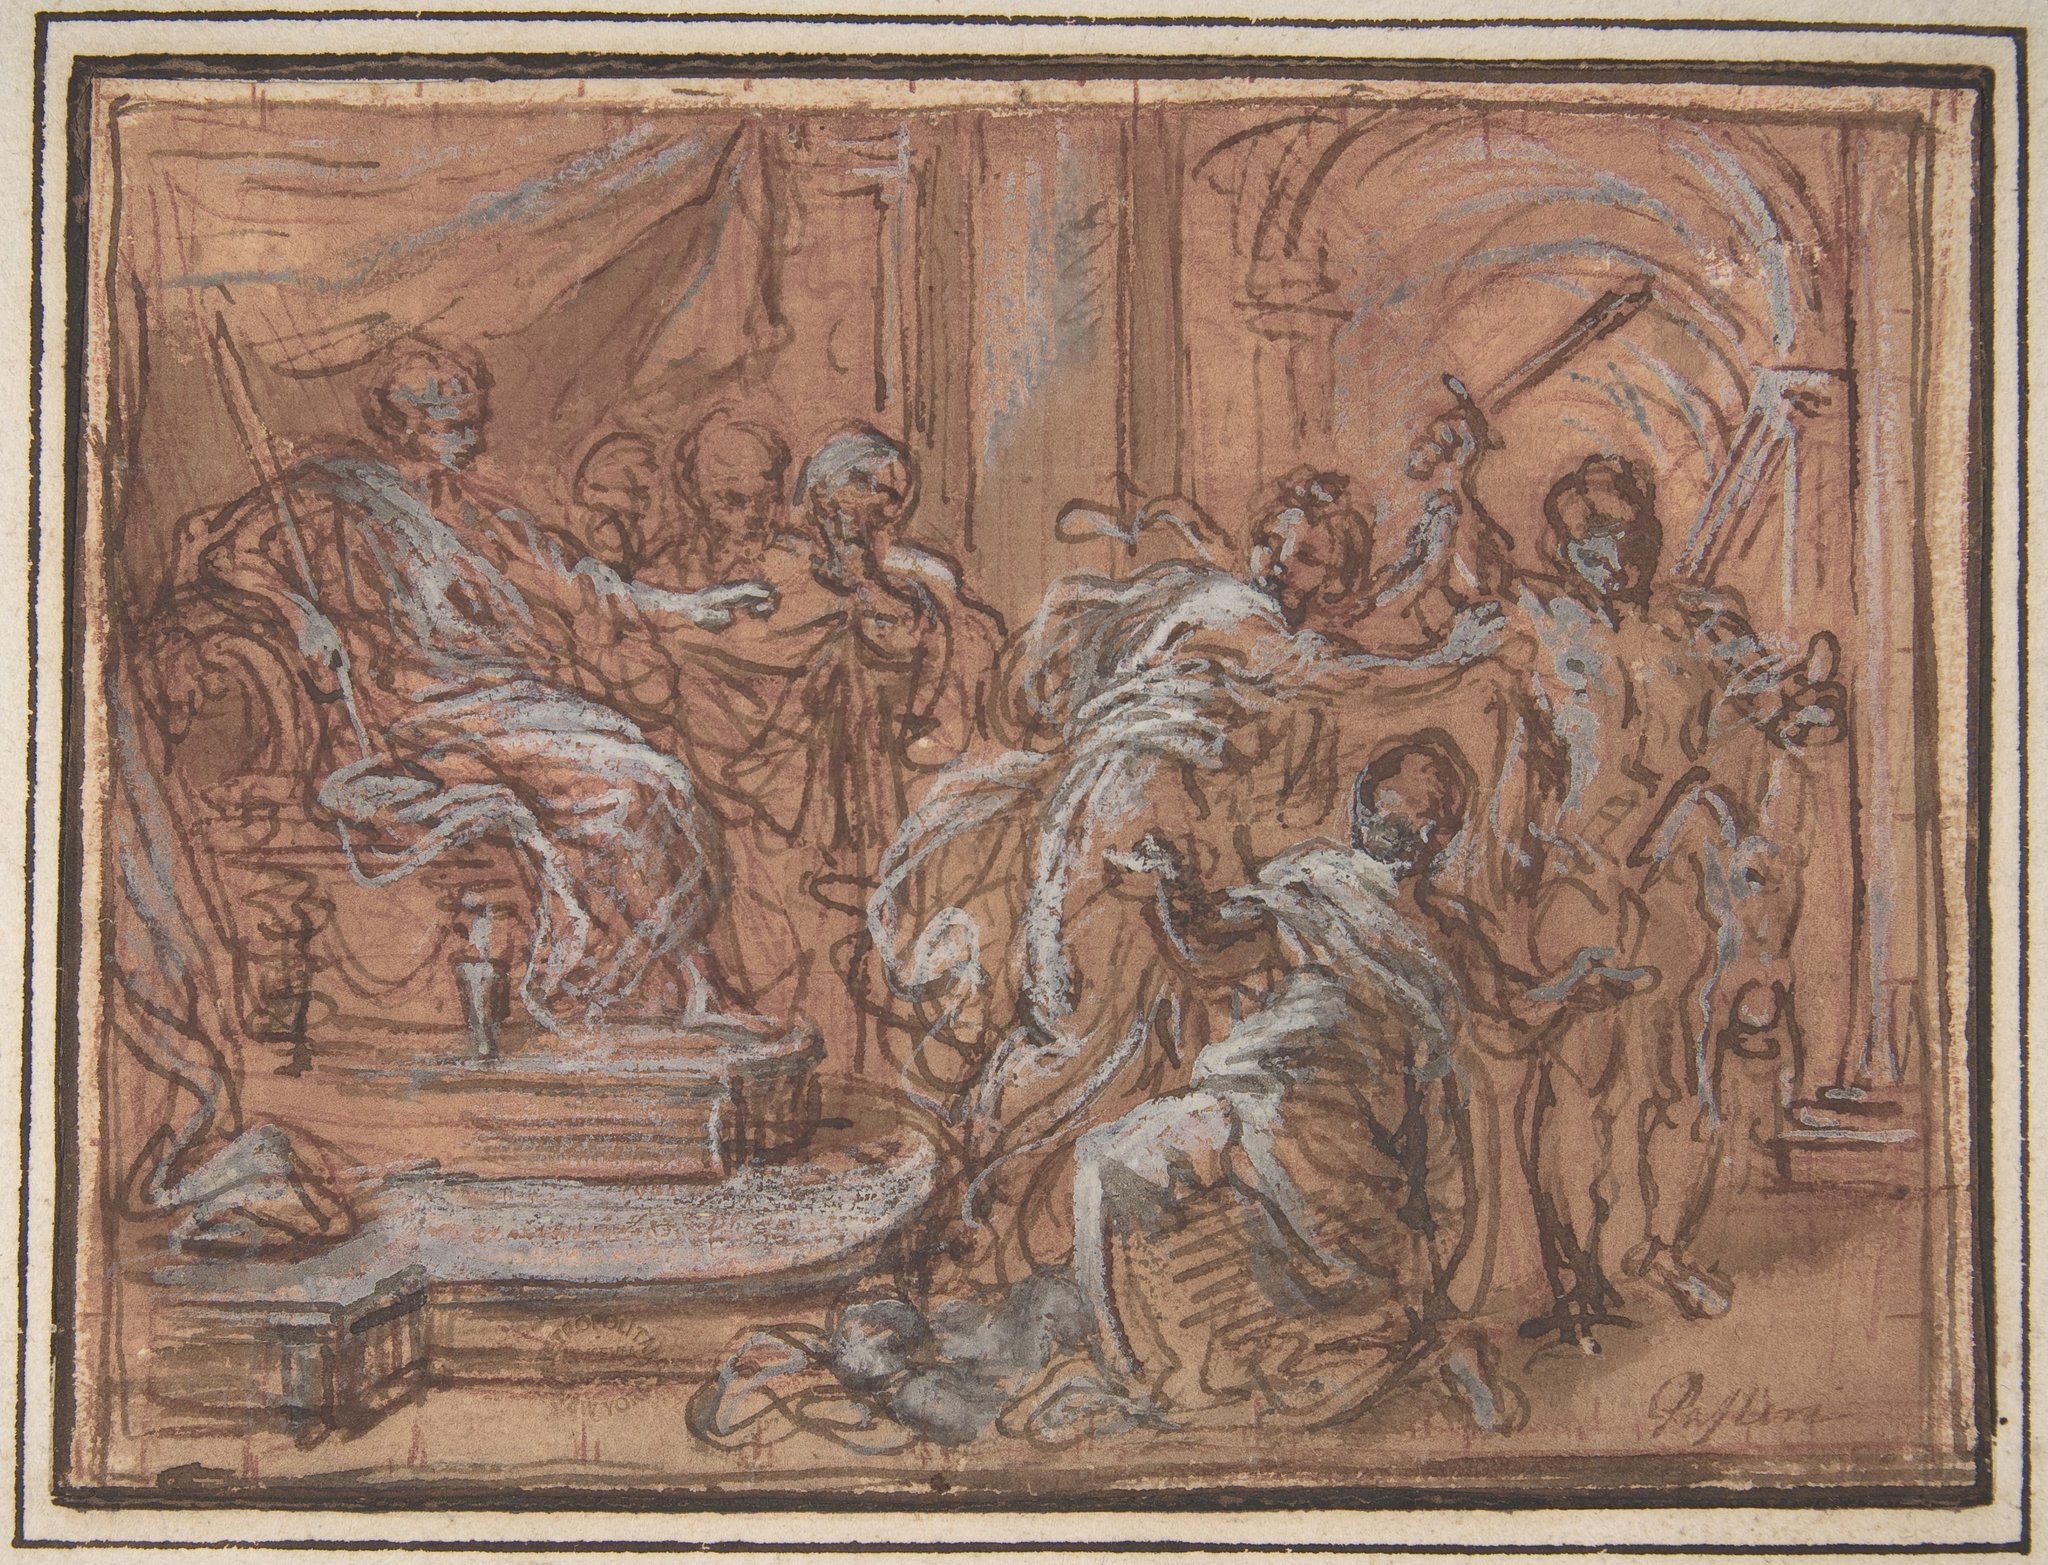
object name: drawing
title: The Judgment of Solomon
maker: giuseppe passeri (passari)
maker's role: artist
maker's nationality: italian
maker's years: 1654-1714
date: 1654-1714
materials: chalk, ink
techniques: brush, highlighting, pen, wash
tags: human figures,kings,bible